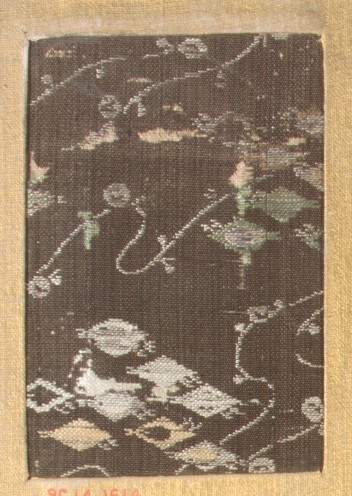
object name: piece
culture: japanese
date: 1701-1900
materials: silk